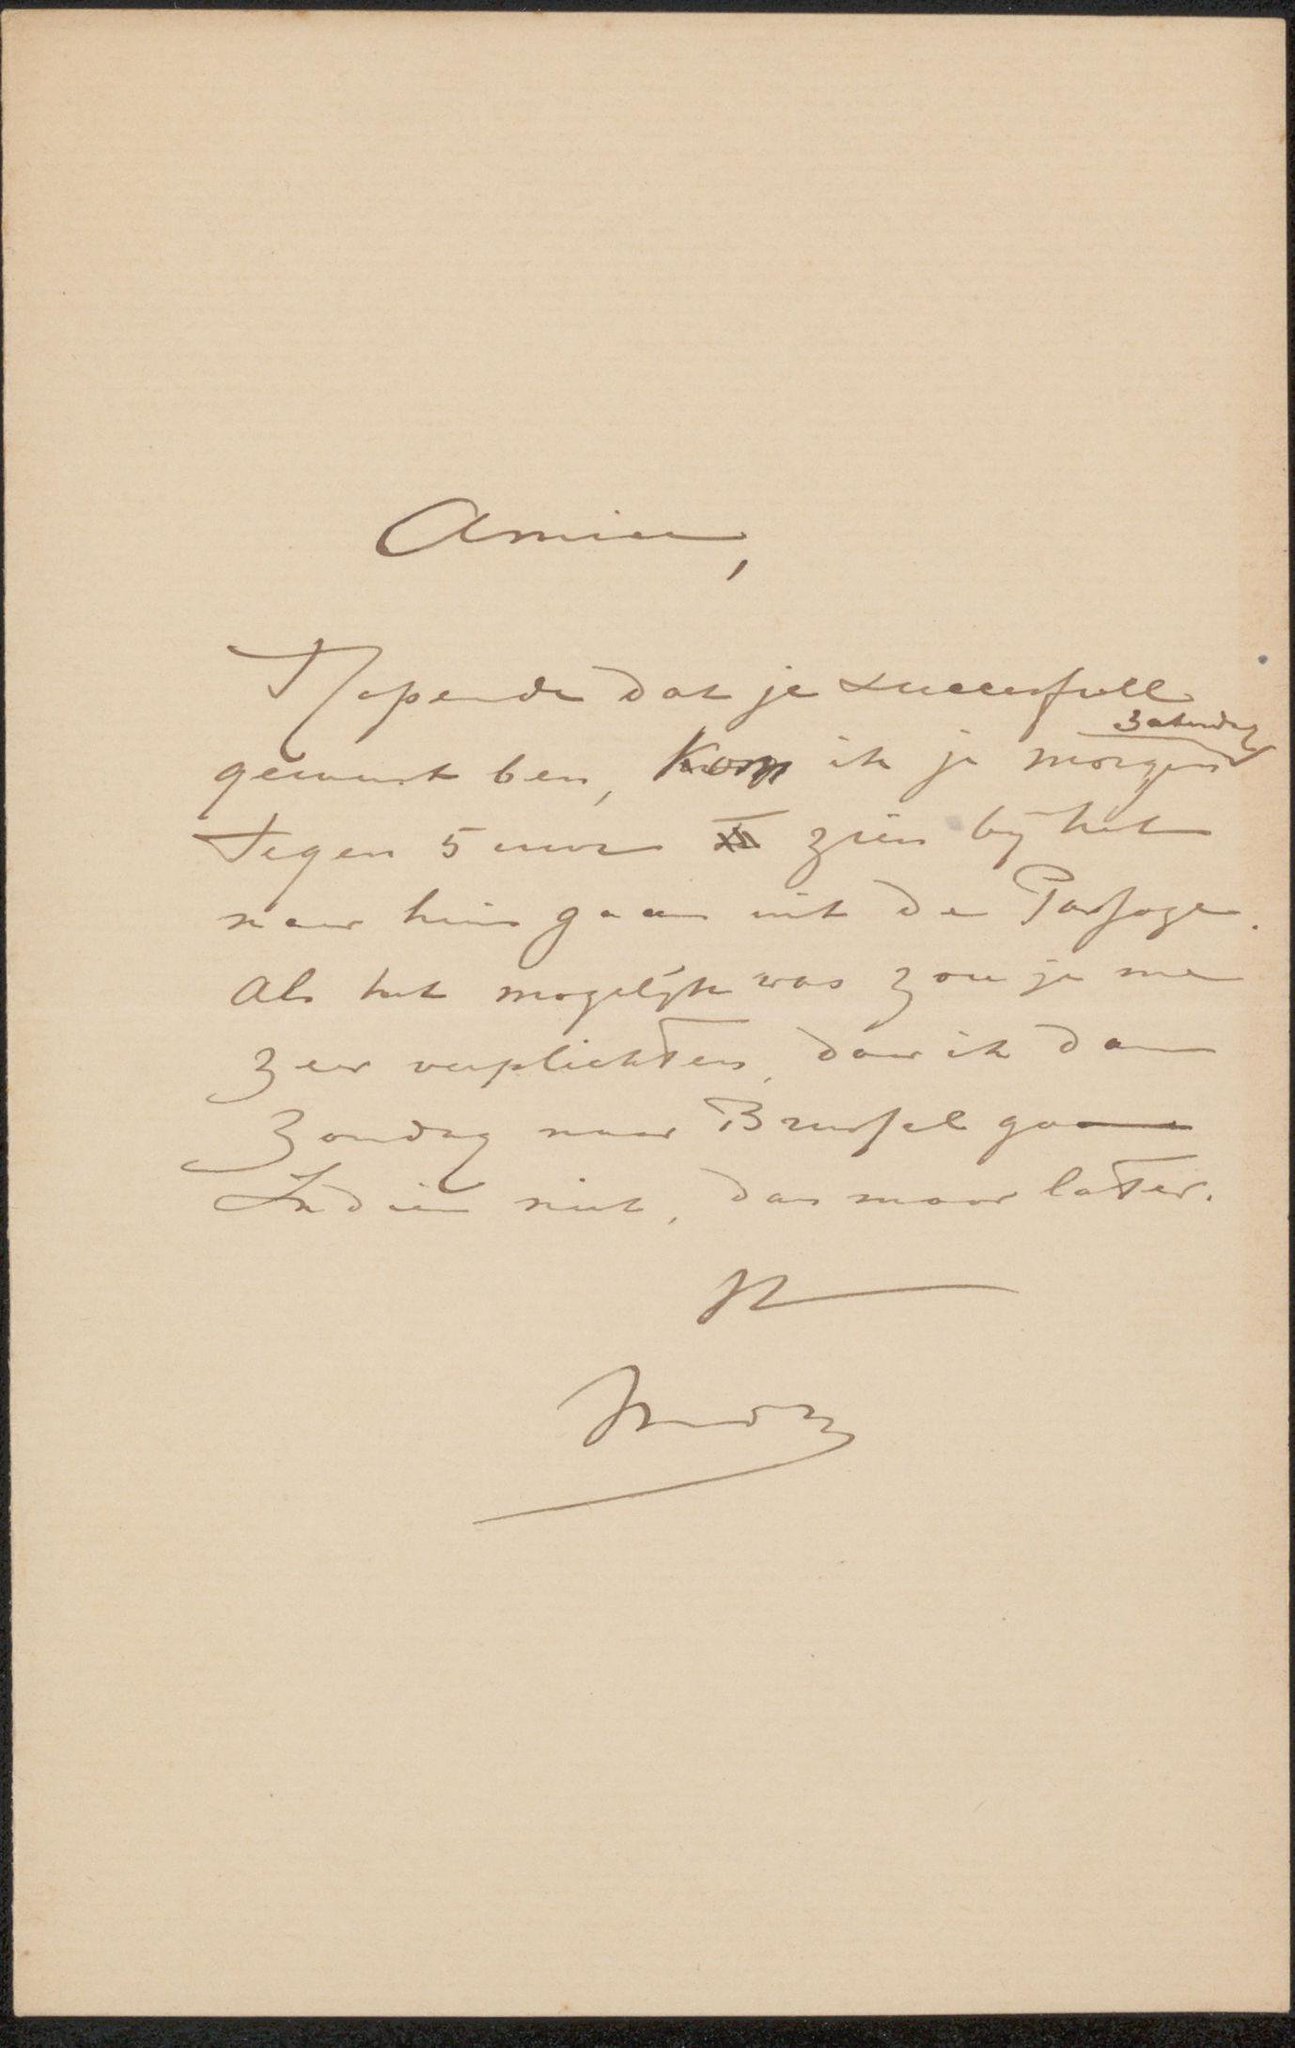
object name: letter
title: Brief aan Philip Zilcken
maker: marinus van der maarel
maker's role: draughtsman, painter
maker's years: 1857-1921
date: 1867-1921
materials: ink, paper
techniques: pen, writing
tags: philip zilcken, brussels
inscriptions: collector's mark: ‘RPK’